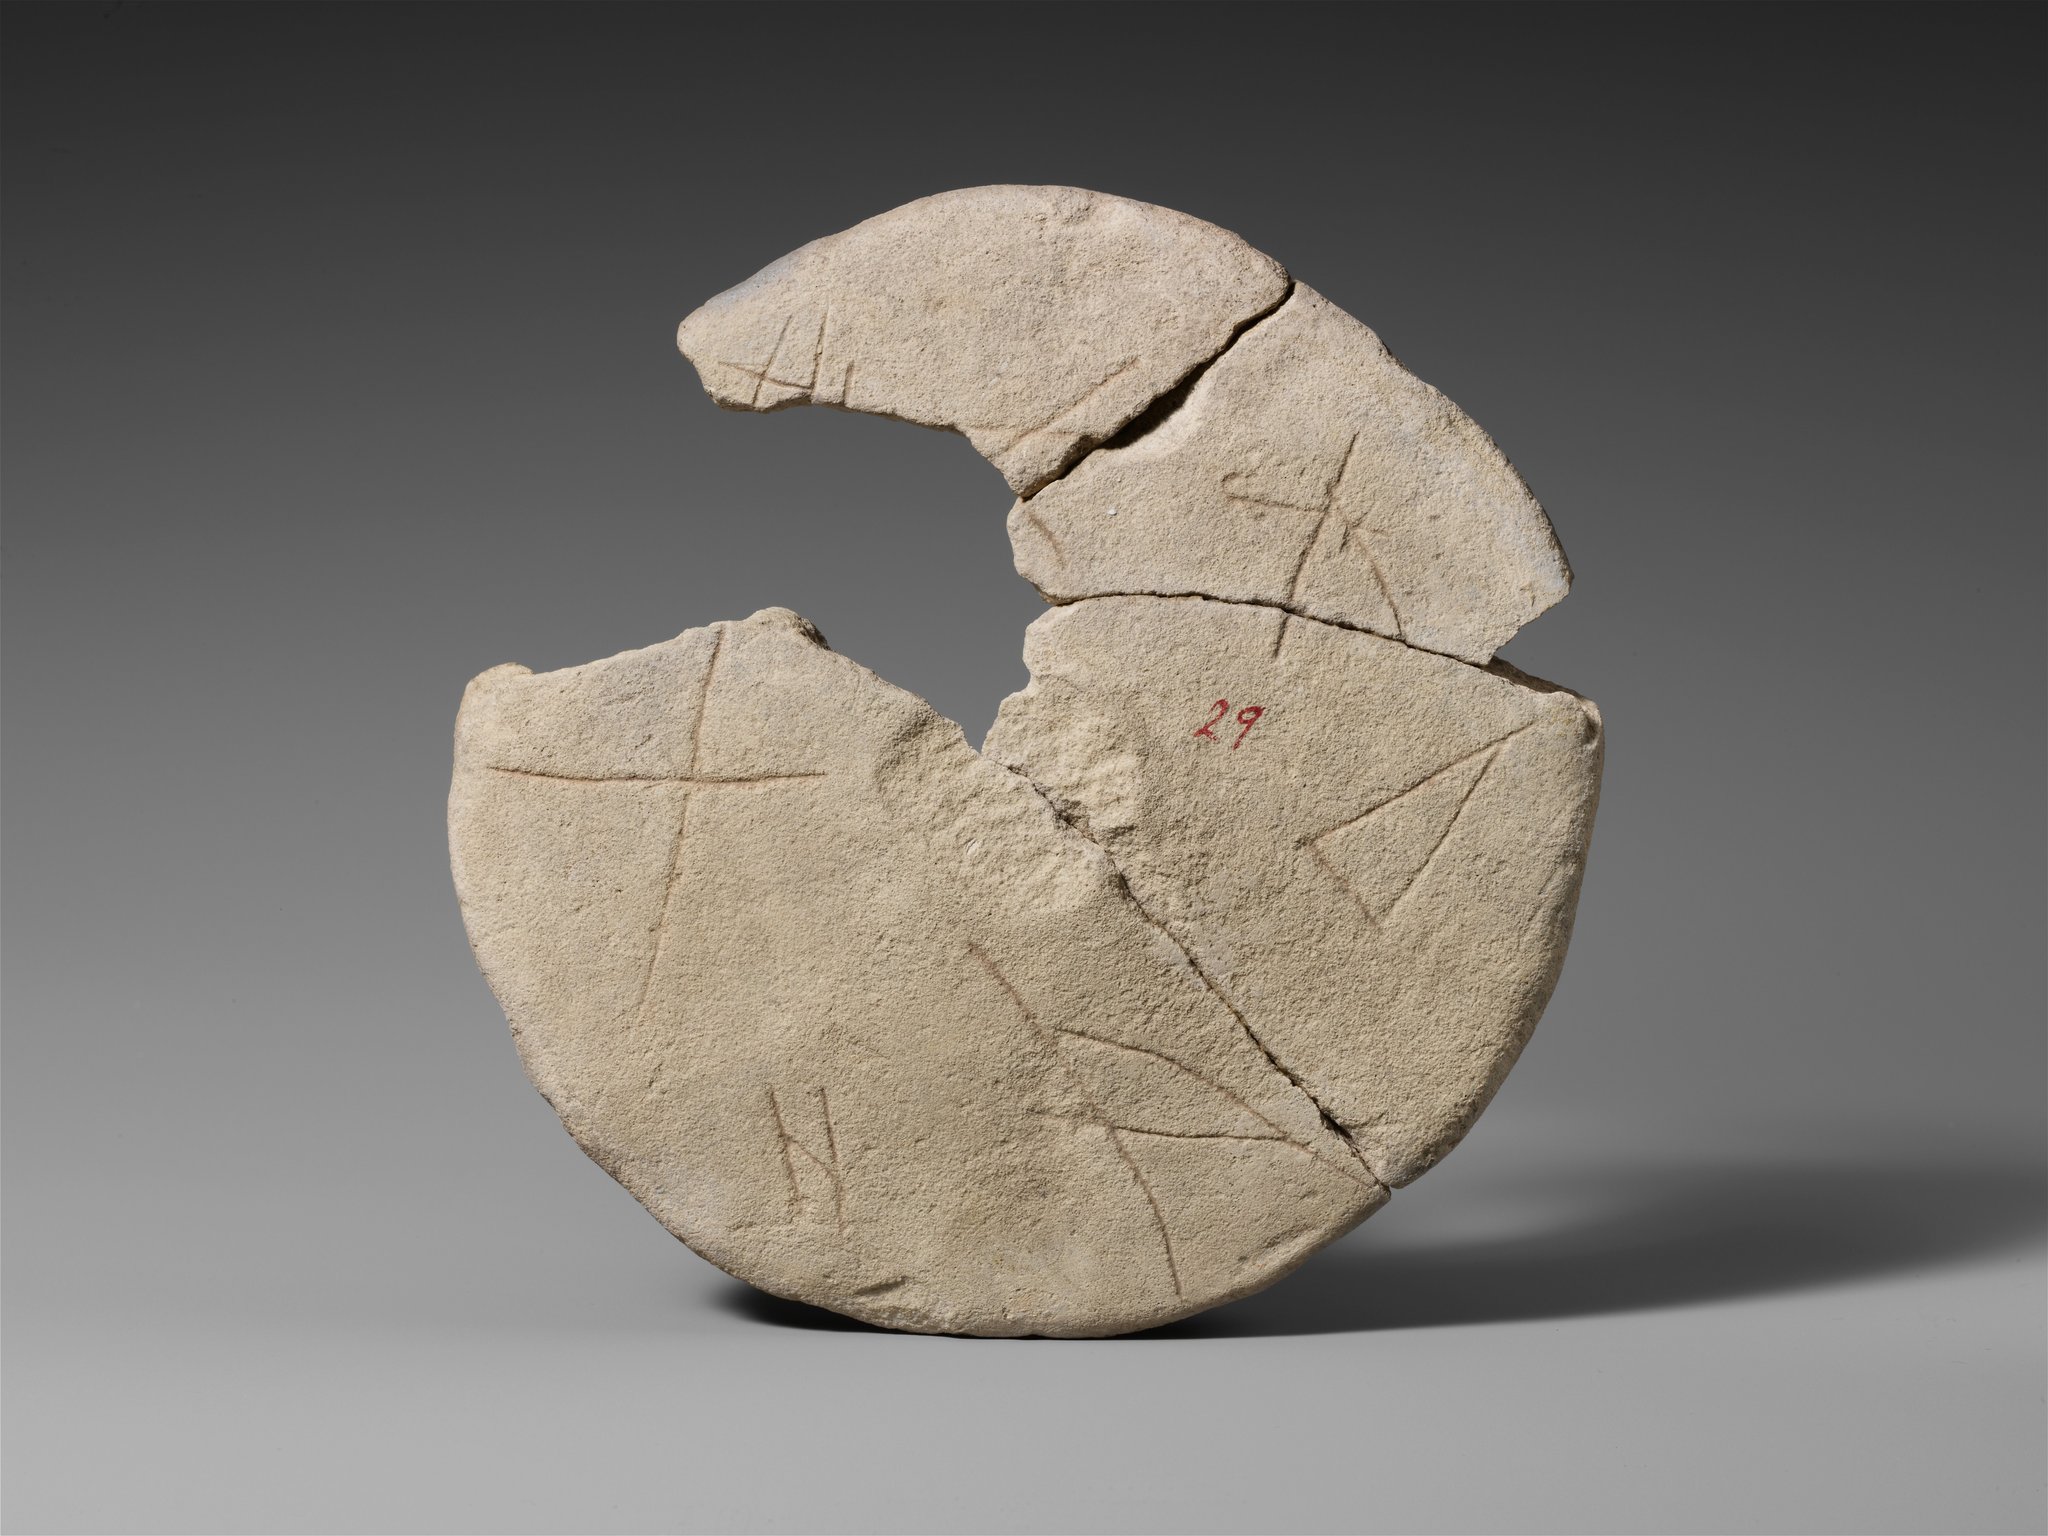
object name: vase foot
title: Limestone inscribed disk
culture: cypriot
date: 3900 BCE-100 CE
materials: limestone